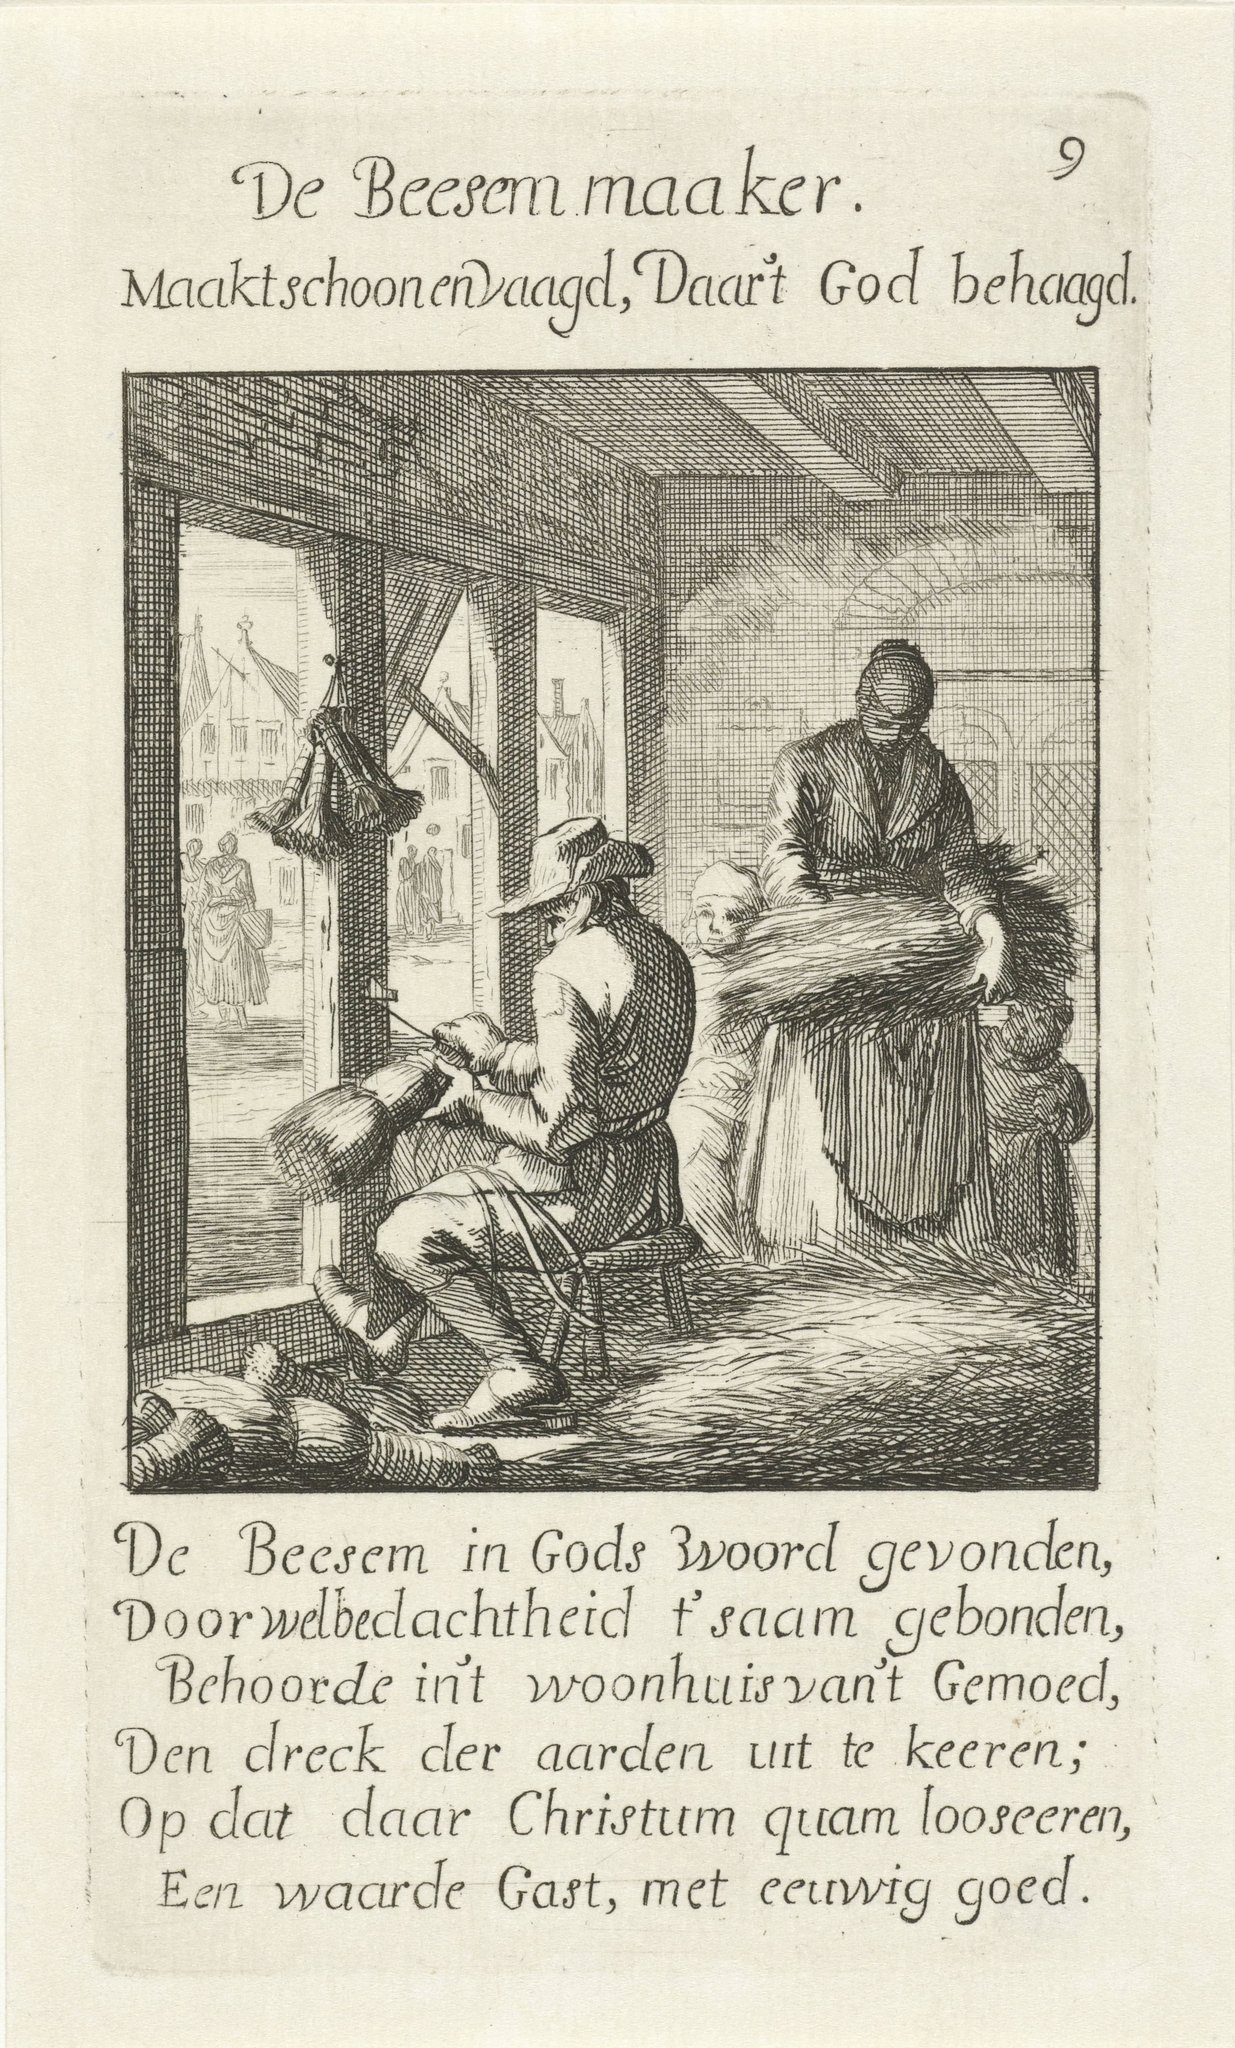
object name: print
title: De Beesemmaaker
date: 1694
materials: paper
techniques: etching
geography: amsterdam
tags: handicrafts, craftsman at work, shrubs: broom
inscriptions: collector's mark: Lugt 2228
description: Maakt deel uit van de 100-delige serie beroepsprenten van Jan en Caspar Luyken, getiteld: Het menselyk bedryf. S.l.s.n., 1694 (eerste druk).